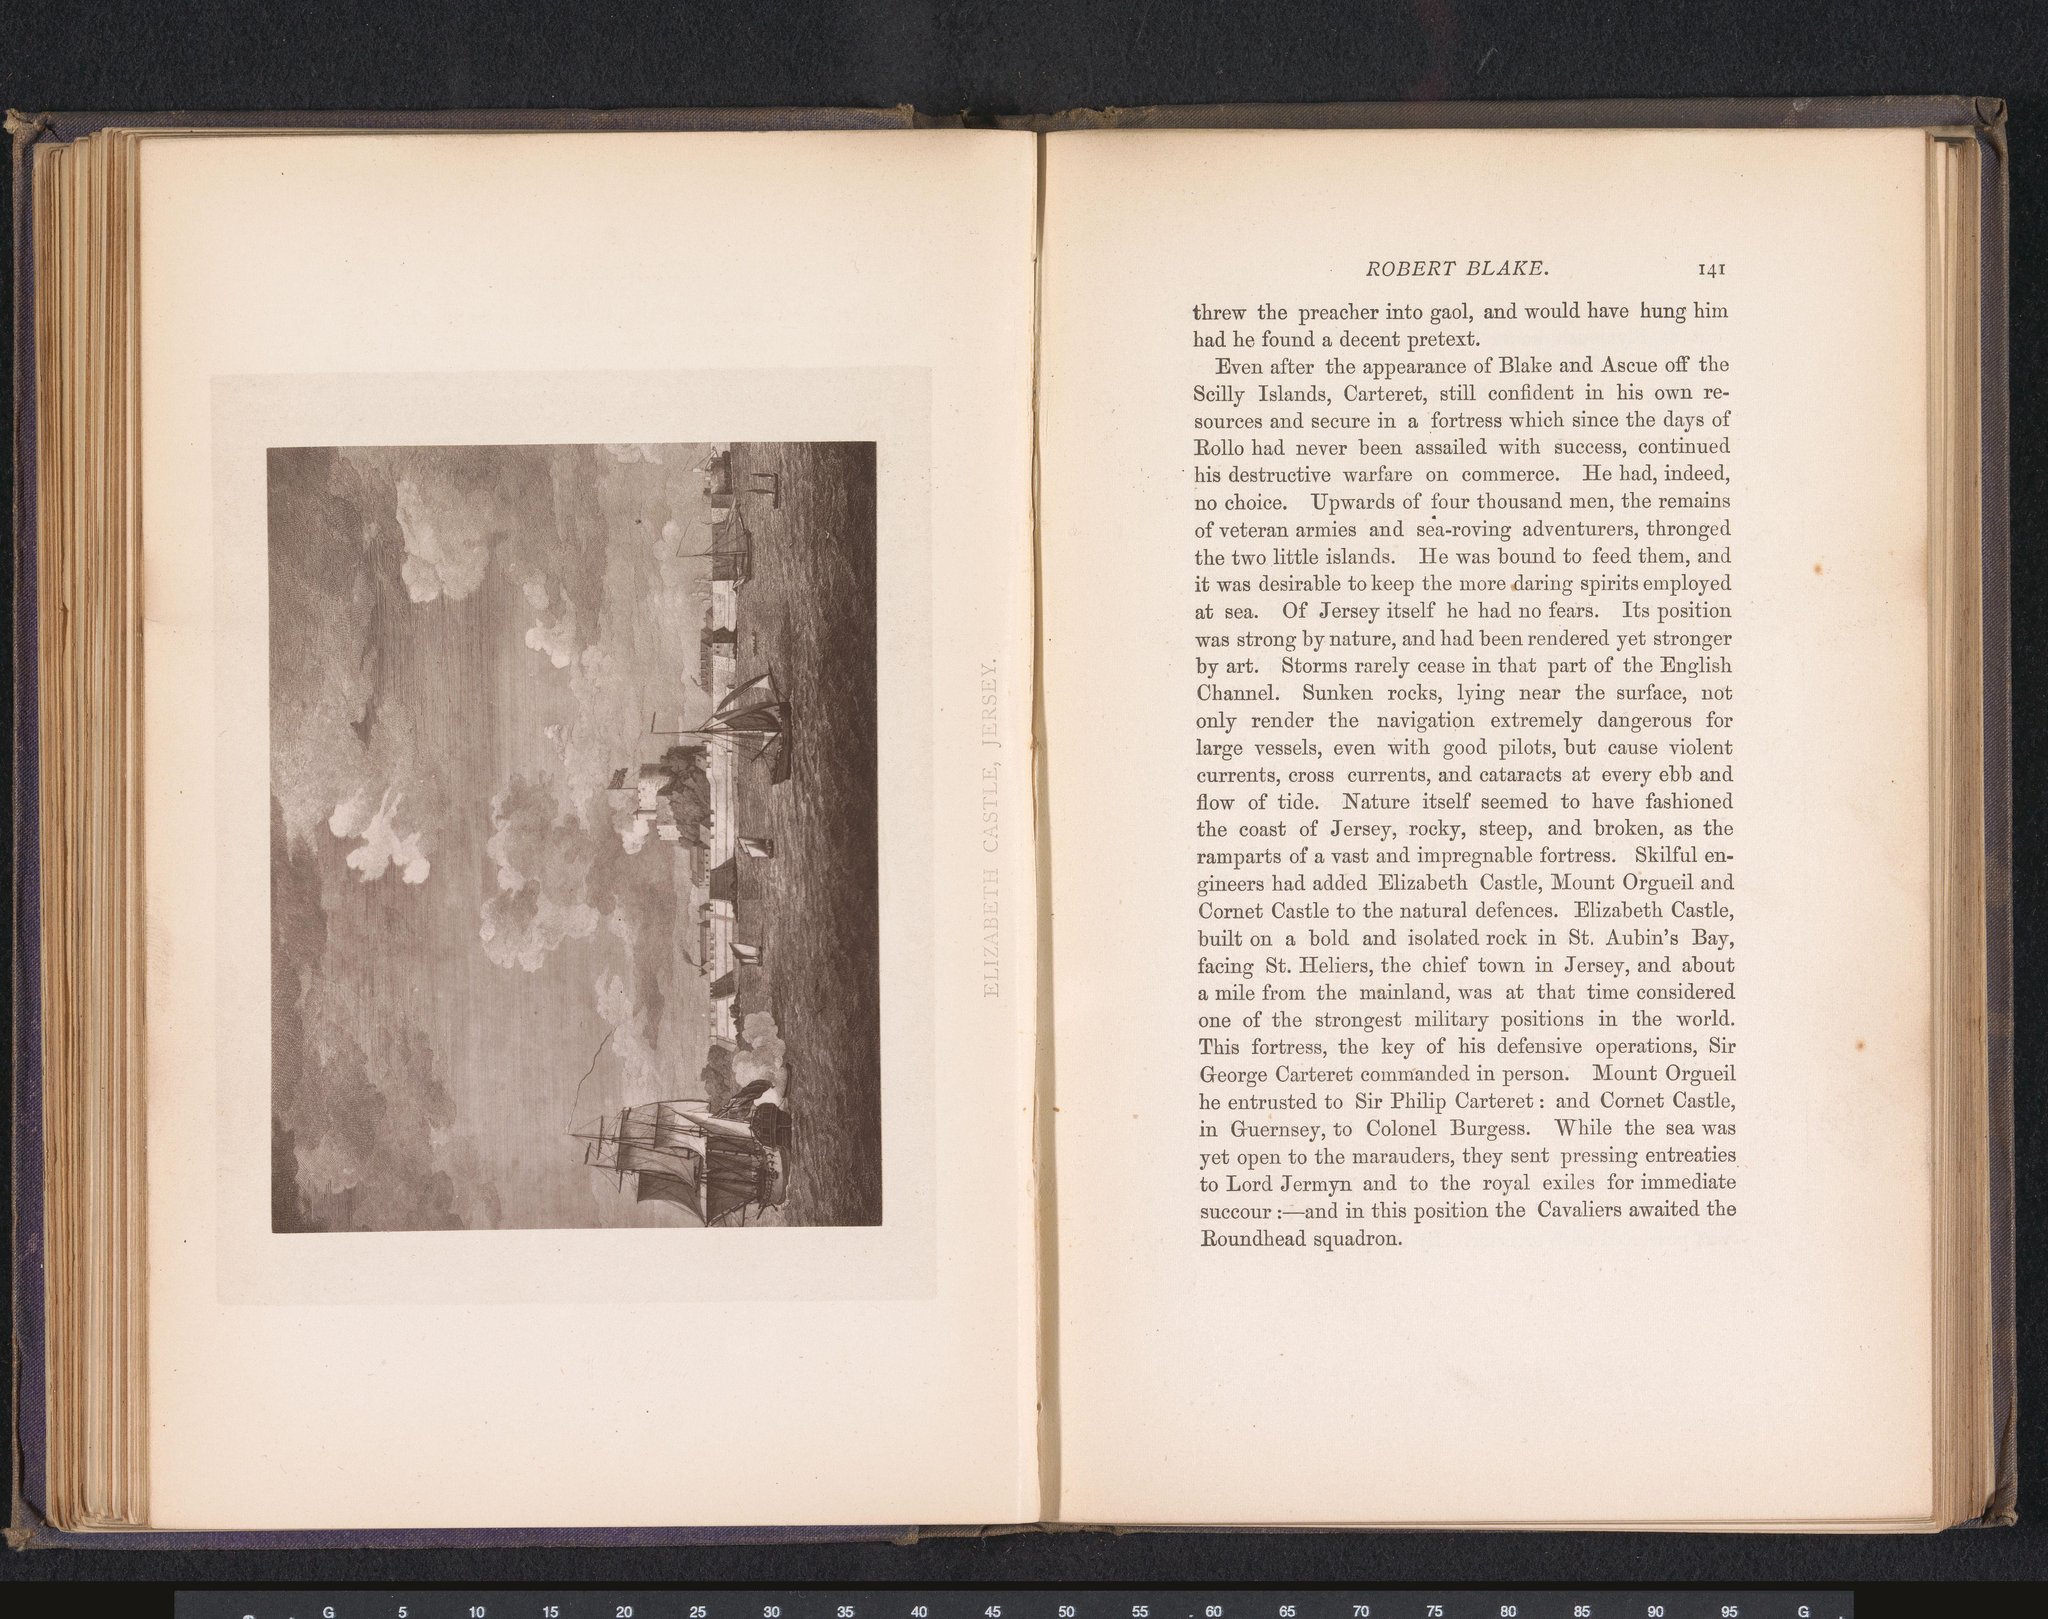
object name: photomechanical print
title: Elisabeth Castle, Jersey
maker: Anonymous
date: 1875-1885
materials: paper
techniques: woodburytype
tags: fortress